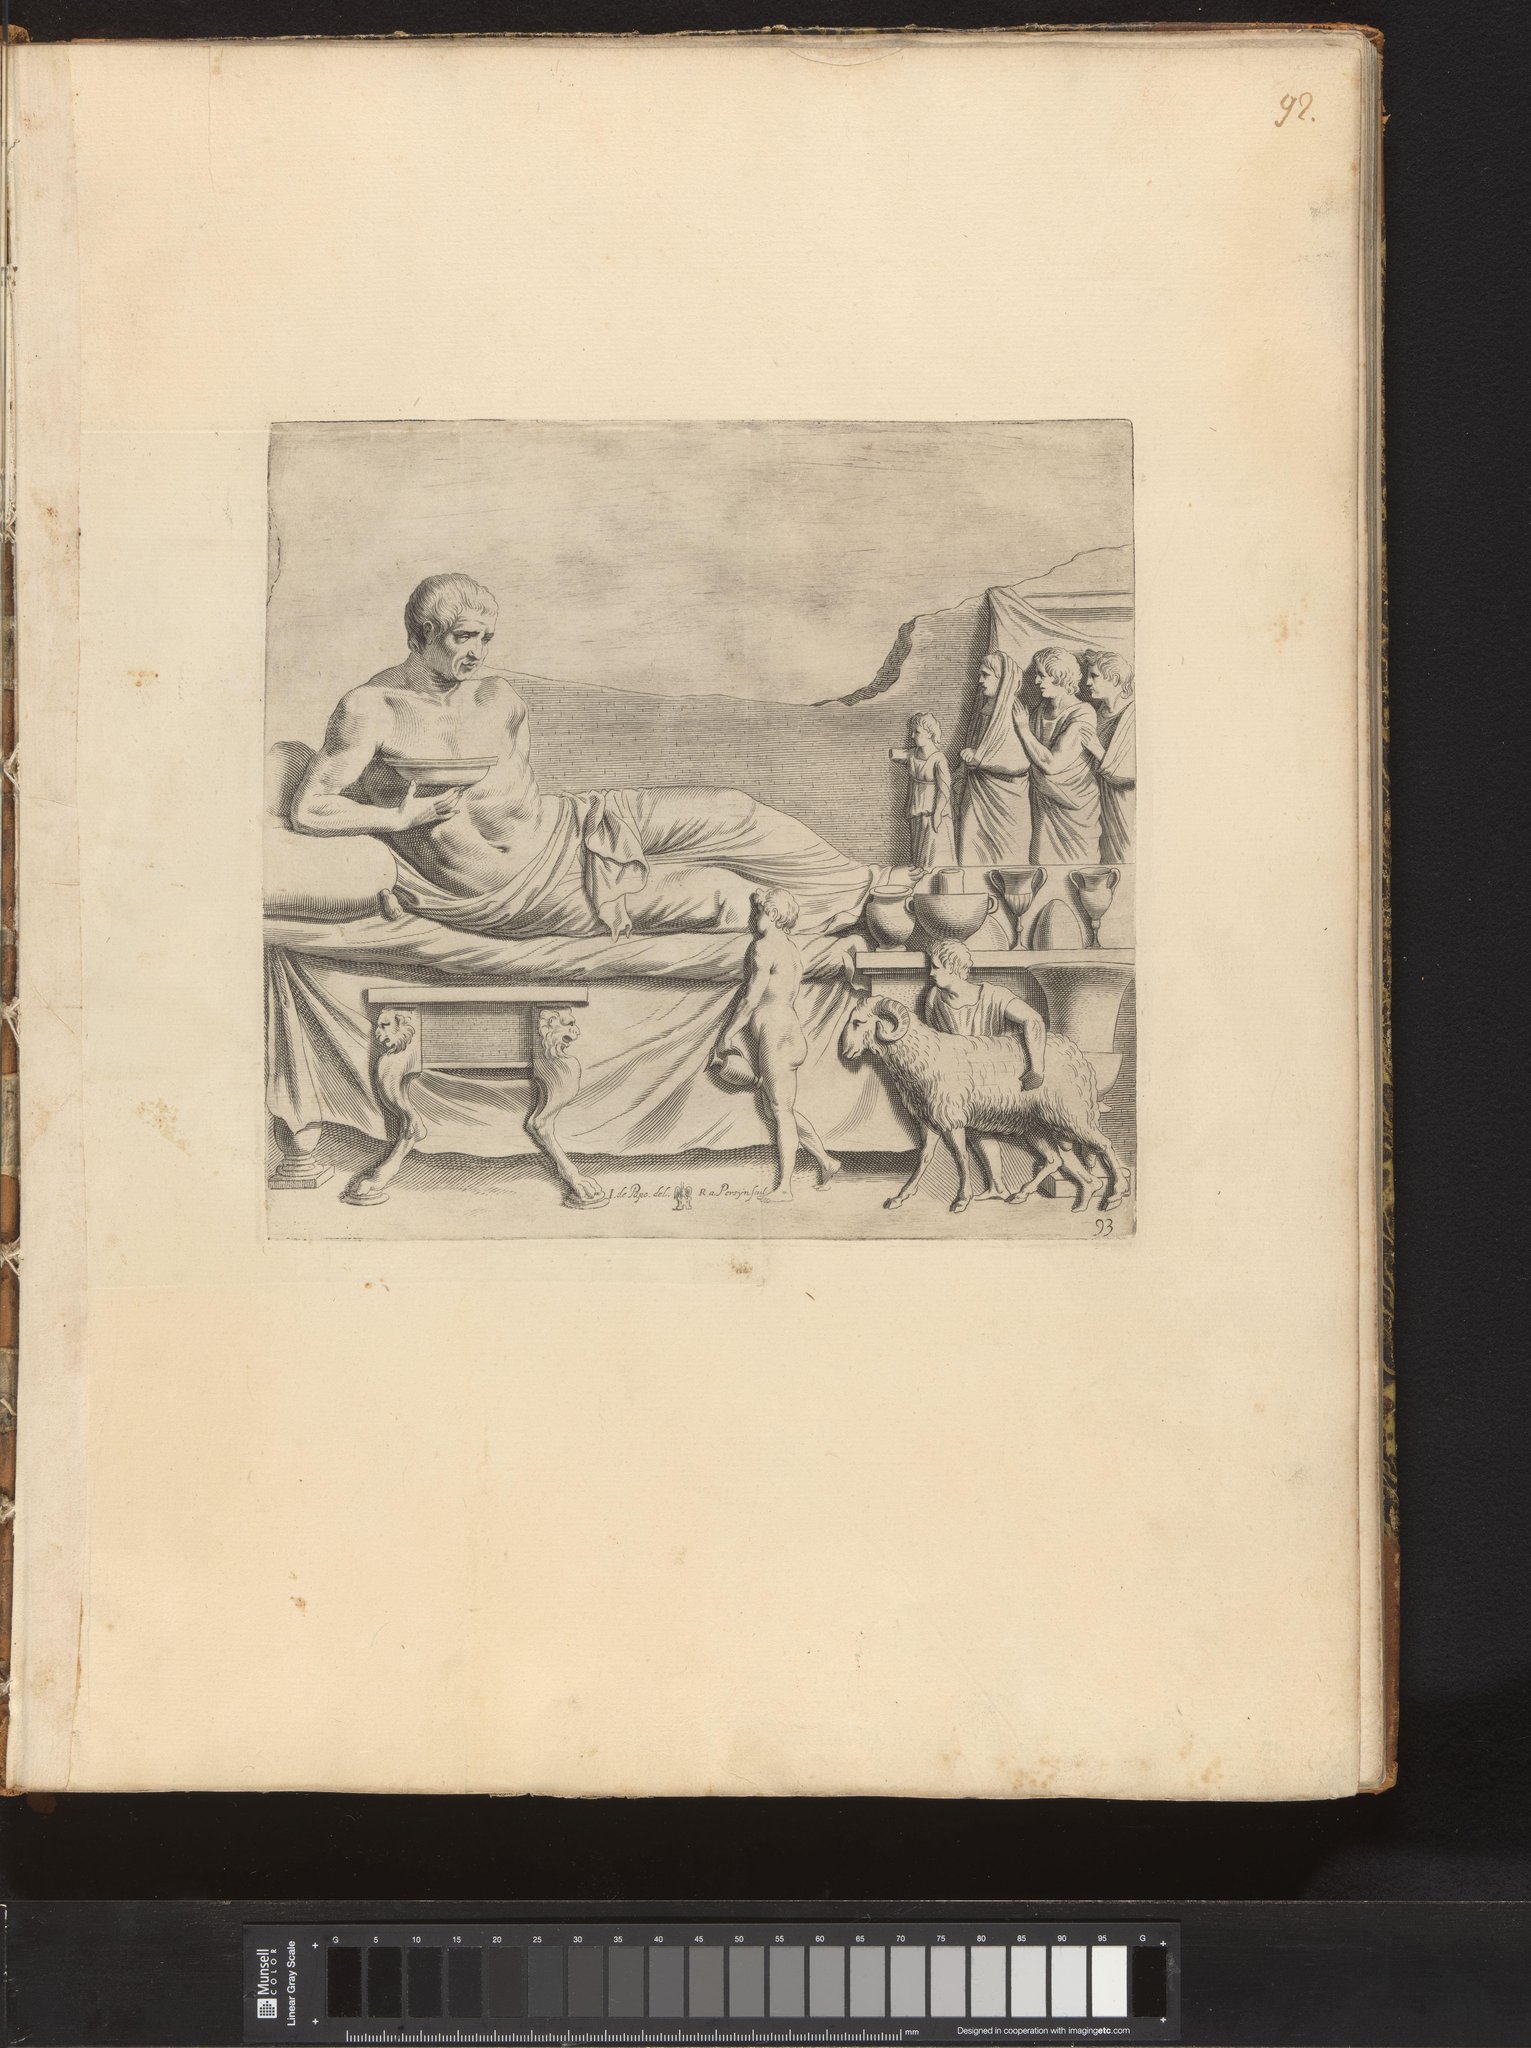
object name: album leaf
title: Galleria Giustiniana del Marchese Vincenzo Giustiniani II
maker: reinier van persijn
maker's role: draughtsman, painter, print maker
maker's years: 1614-1668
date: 1636-1647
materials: paper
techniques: engraving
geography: rome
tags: piece of sculpture, reproduction of a piece of sculpture, cupids: 'amores', 'amoretti', 'putti'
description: Romeins bas-reliëf van een groep putti, van wie er twee een portret vasthouden. (Waarschijnlijk een fragment van een sacrcofaag.) Midden onder het wapenschild van Vincenzo Giustiniani. Prent maakt deel uit van een album met een serie prenten naar de sculpturen in de verzameling in de Galleria Giustiniani te Rome.